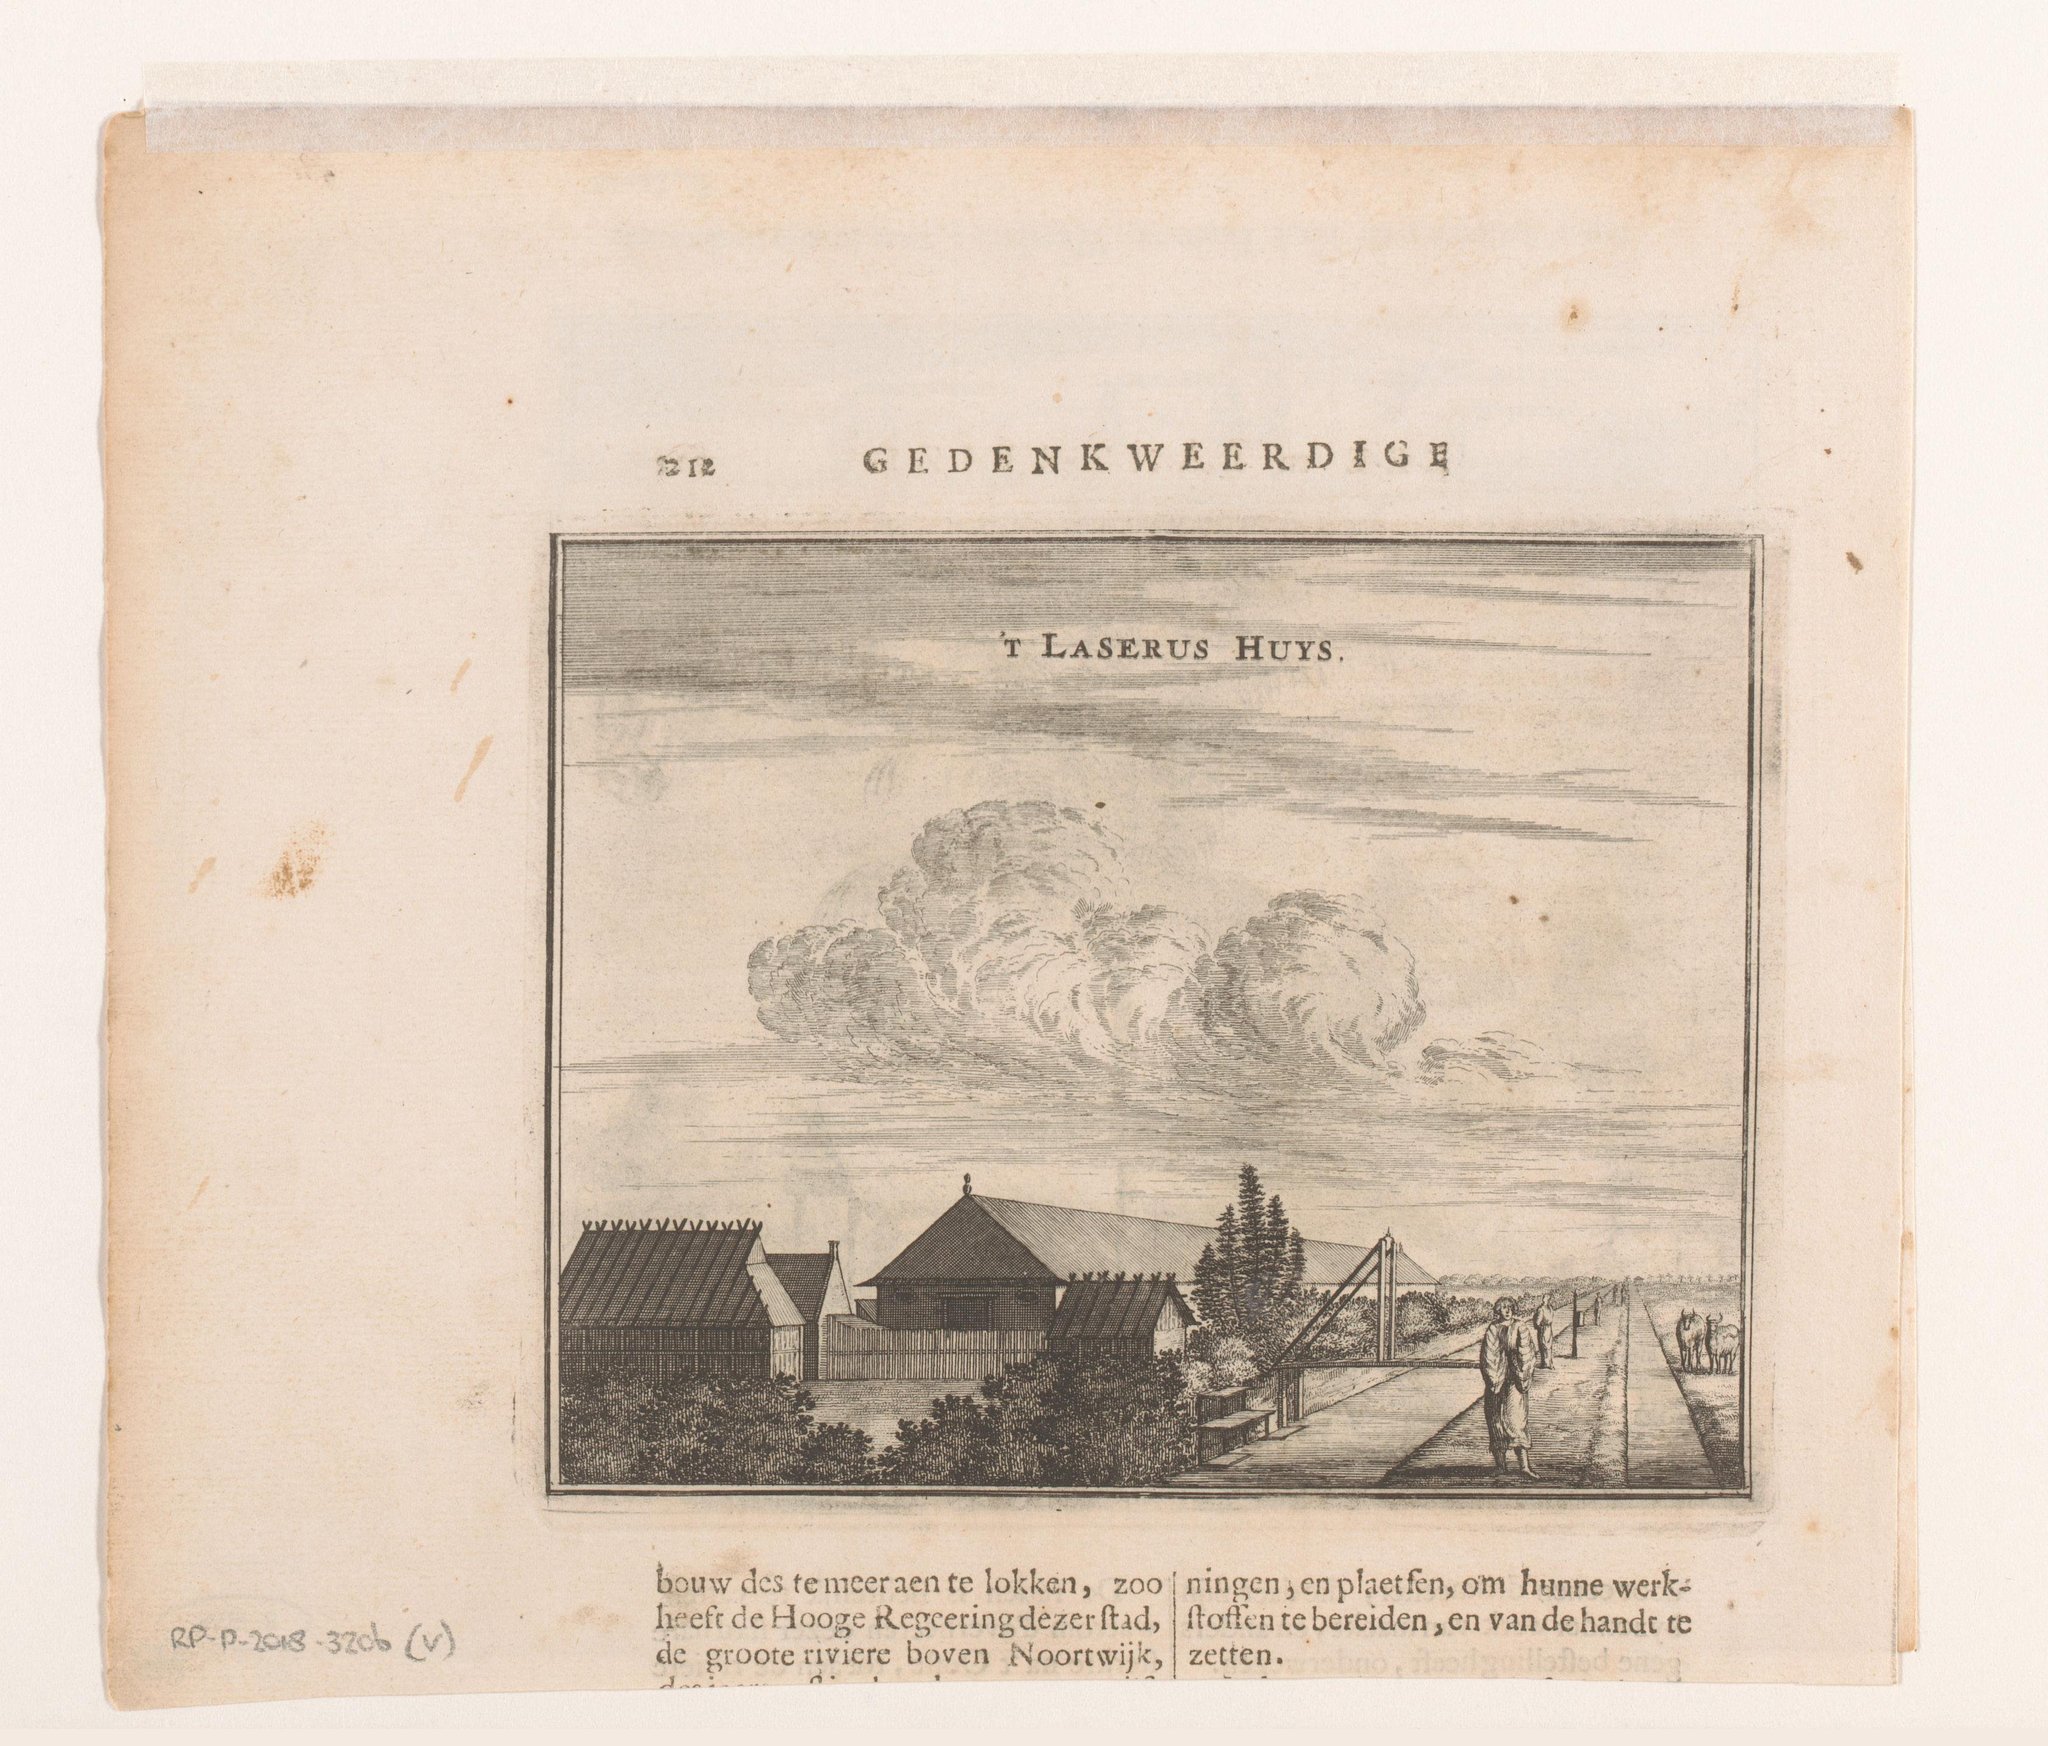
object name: book illustration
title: 't Laserus Huys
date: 1682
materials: paper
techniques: engraving, etching, letterpress printing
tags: leprosarium, batavia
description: Prent uit: Nieuhof, Joan. Joan Nieuhofs zee en lant-reize, door verscheide Gewesten van Oostindien (...). Amsterdam: Jacob van Meurs, 1682, p. 212.